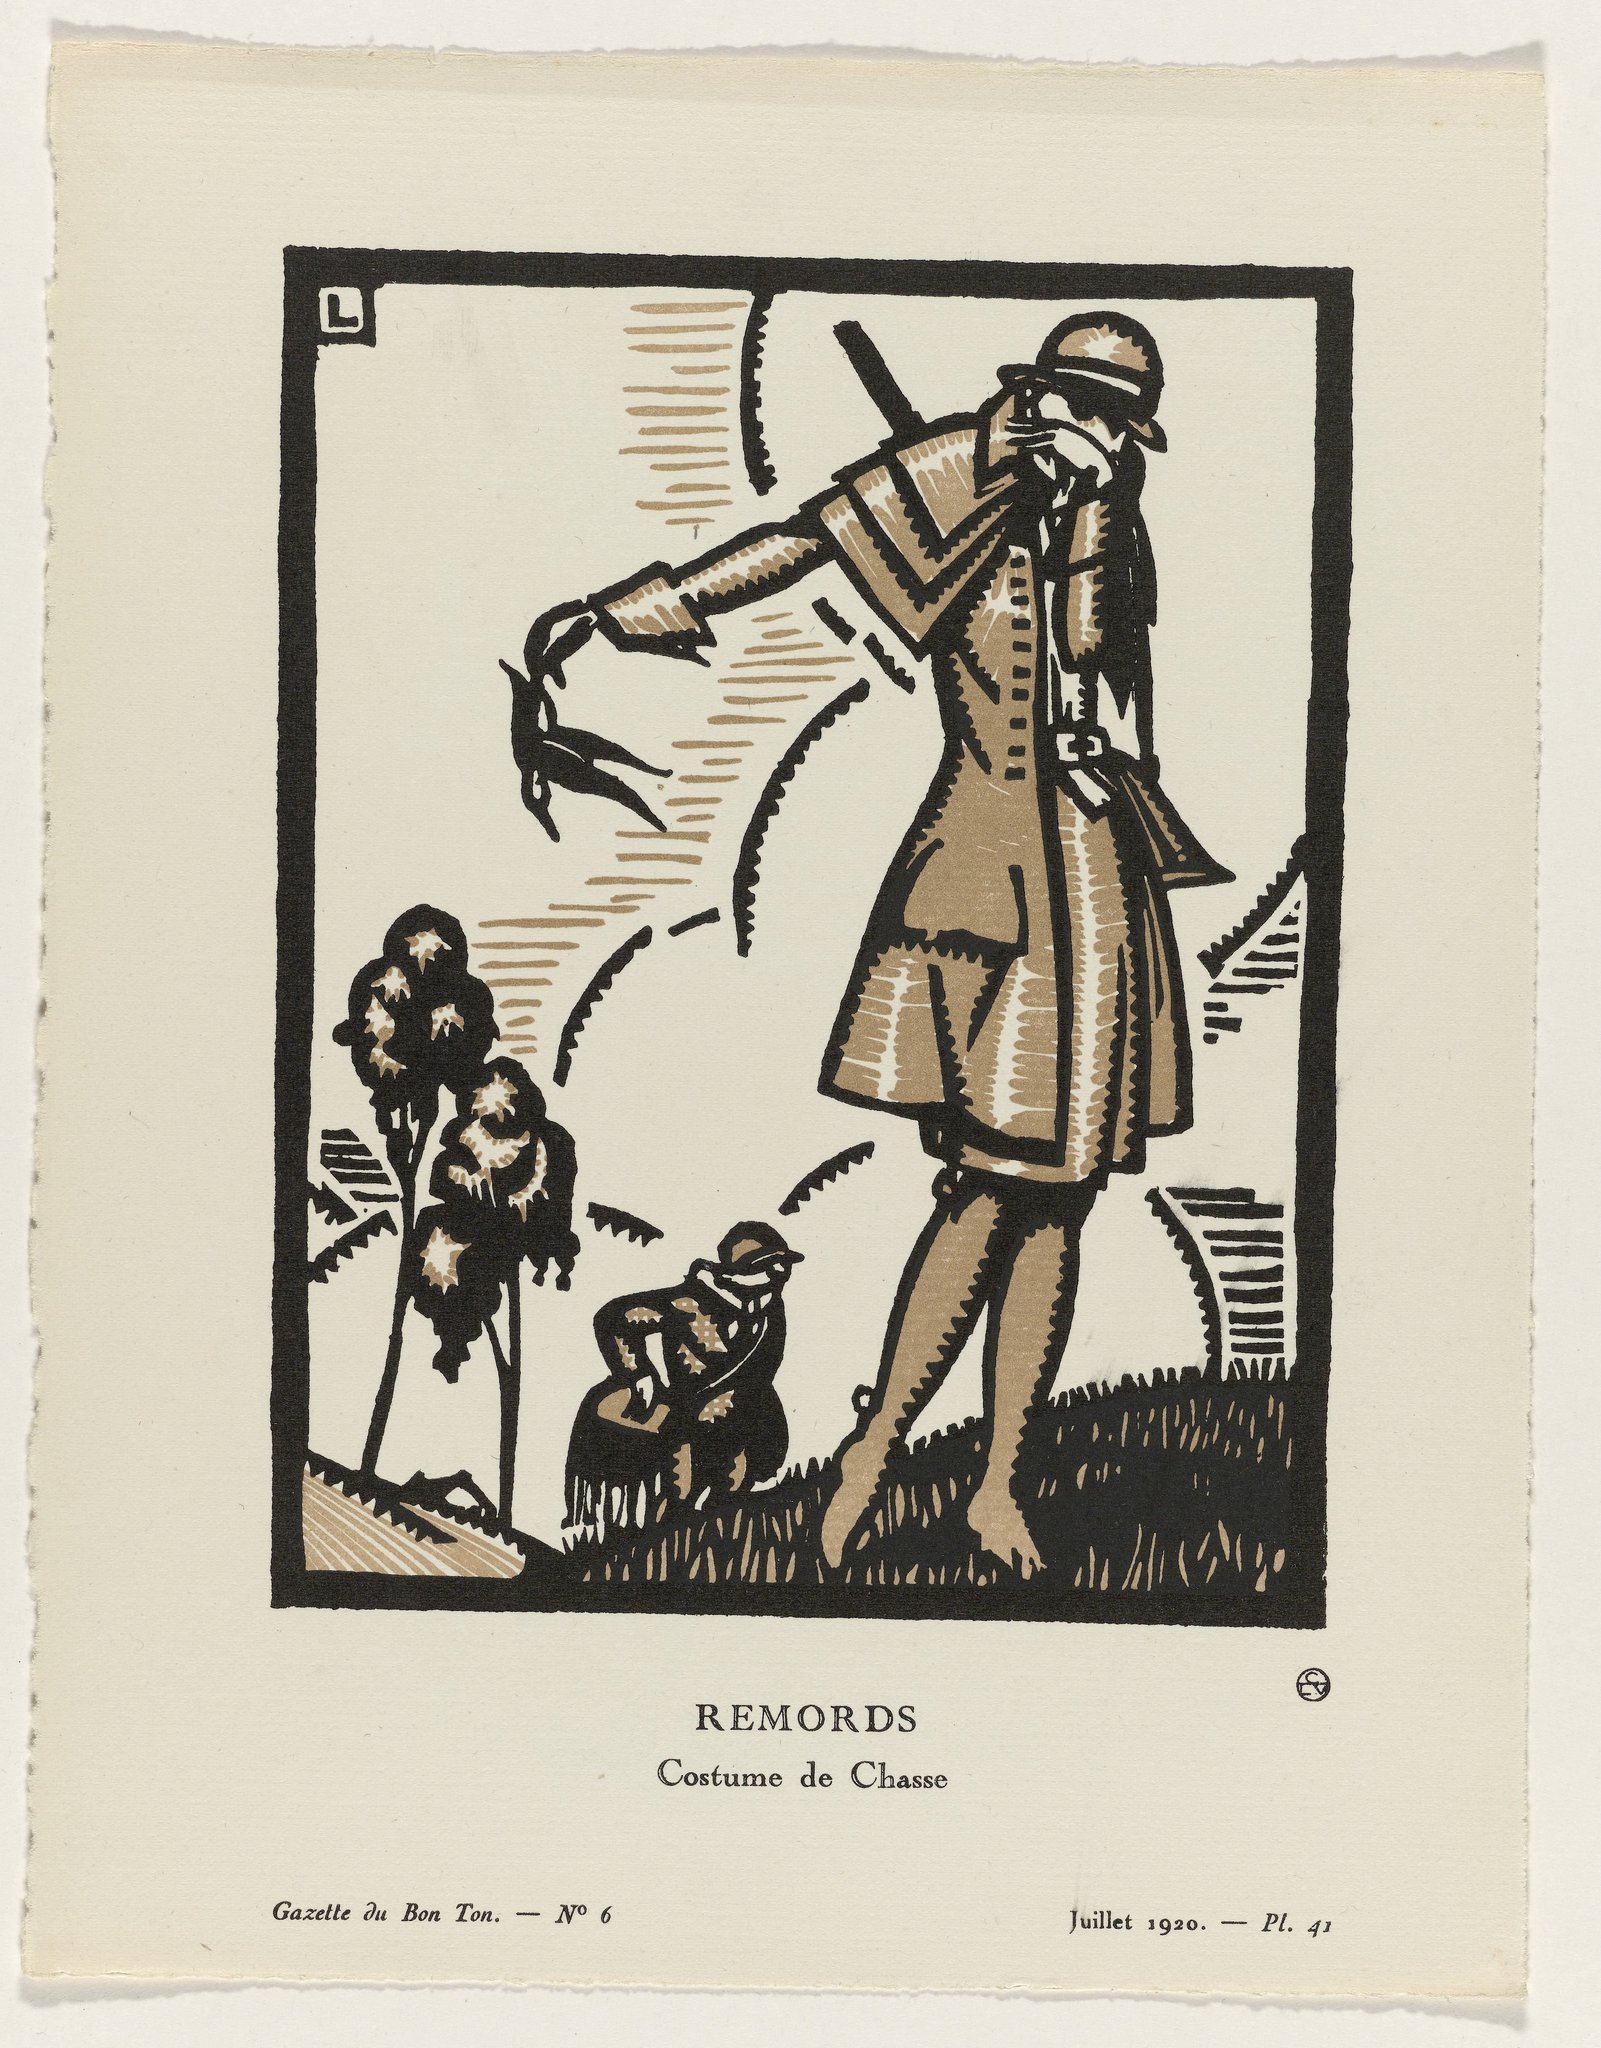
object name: fashion print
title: Gazette du Bon Ton, 1920 - No. 6 : Remords / Costume de Chasse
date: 1920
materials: paper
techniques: lithograph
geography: paris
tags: birds (+ animal killed by man), boots (+ women's clothes), ensembles of pieces of clothing (hunting costume) (+ women's clothes), coat (+ women's clothes), head-gear (+ women's clothes), fashion plates, firearms, neck-gear ~ clothing (+ women's clothes), bird hunting (+ hunting weapons, equipment, outfit)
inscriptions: date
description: Staande vrouw in een landschap met een dode vogel in de hand. Zij draagt een jachtkostuum, bestaande uit een redingote met een kraag in drie lagen, een korte rok en laarzen. Om de linkerschouder een jachtgeweer. Planche 41 uit Gazette du Bon Ton 1920, No. 6. Uitleg over de kleding op pagina "Explication des Planches".